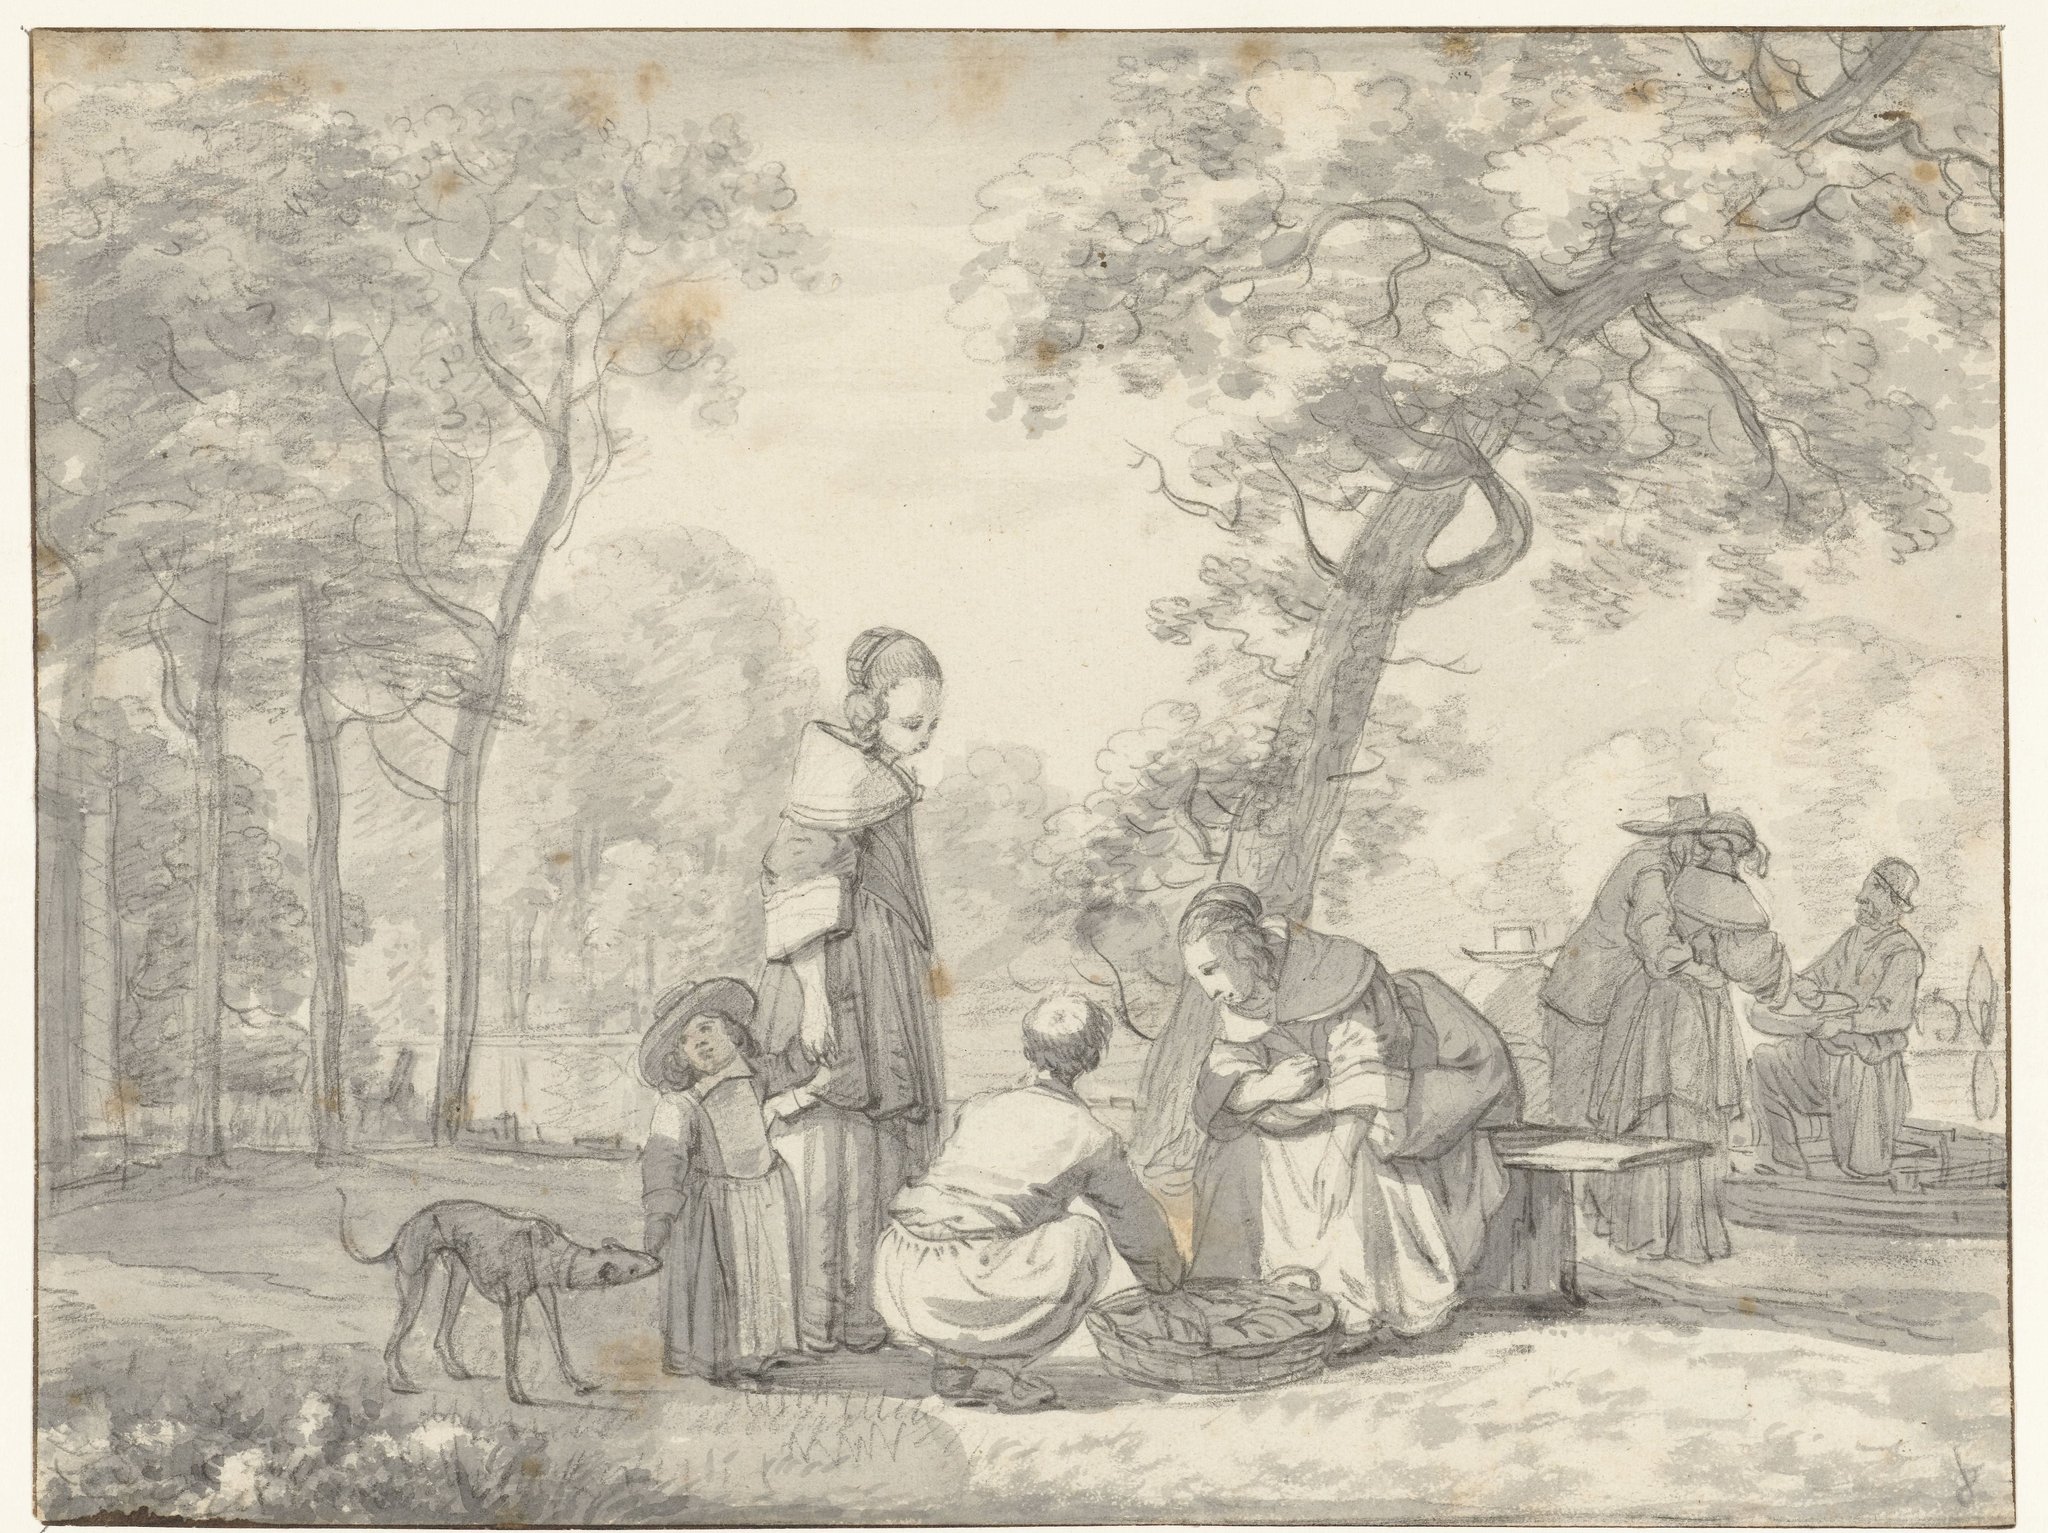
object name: drawing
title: De visboer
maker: jacob esselens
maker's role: draughtsman, print maker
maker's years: 1626-1687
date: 1636-1687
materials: graphite, paper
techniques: brush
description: Kooplui bieden hun waar aan aan mensen naast een rivier.